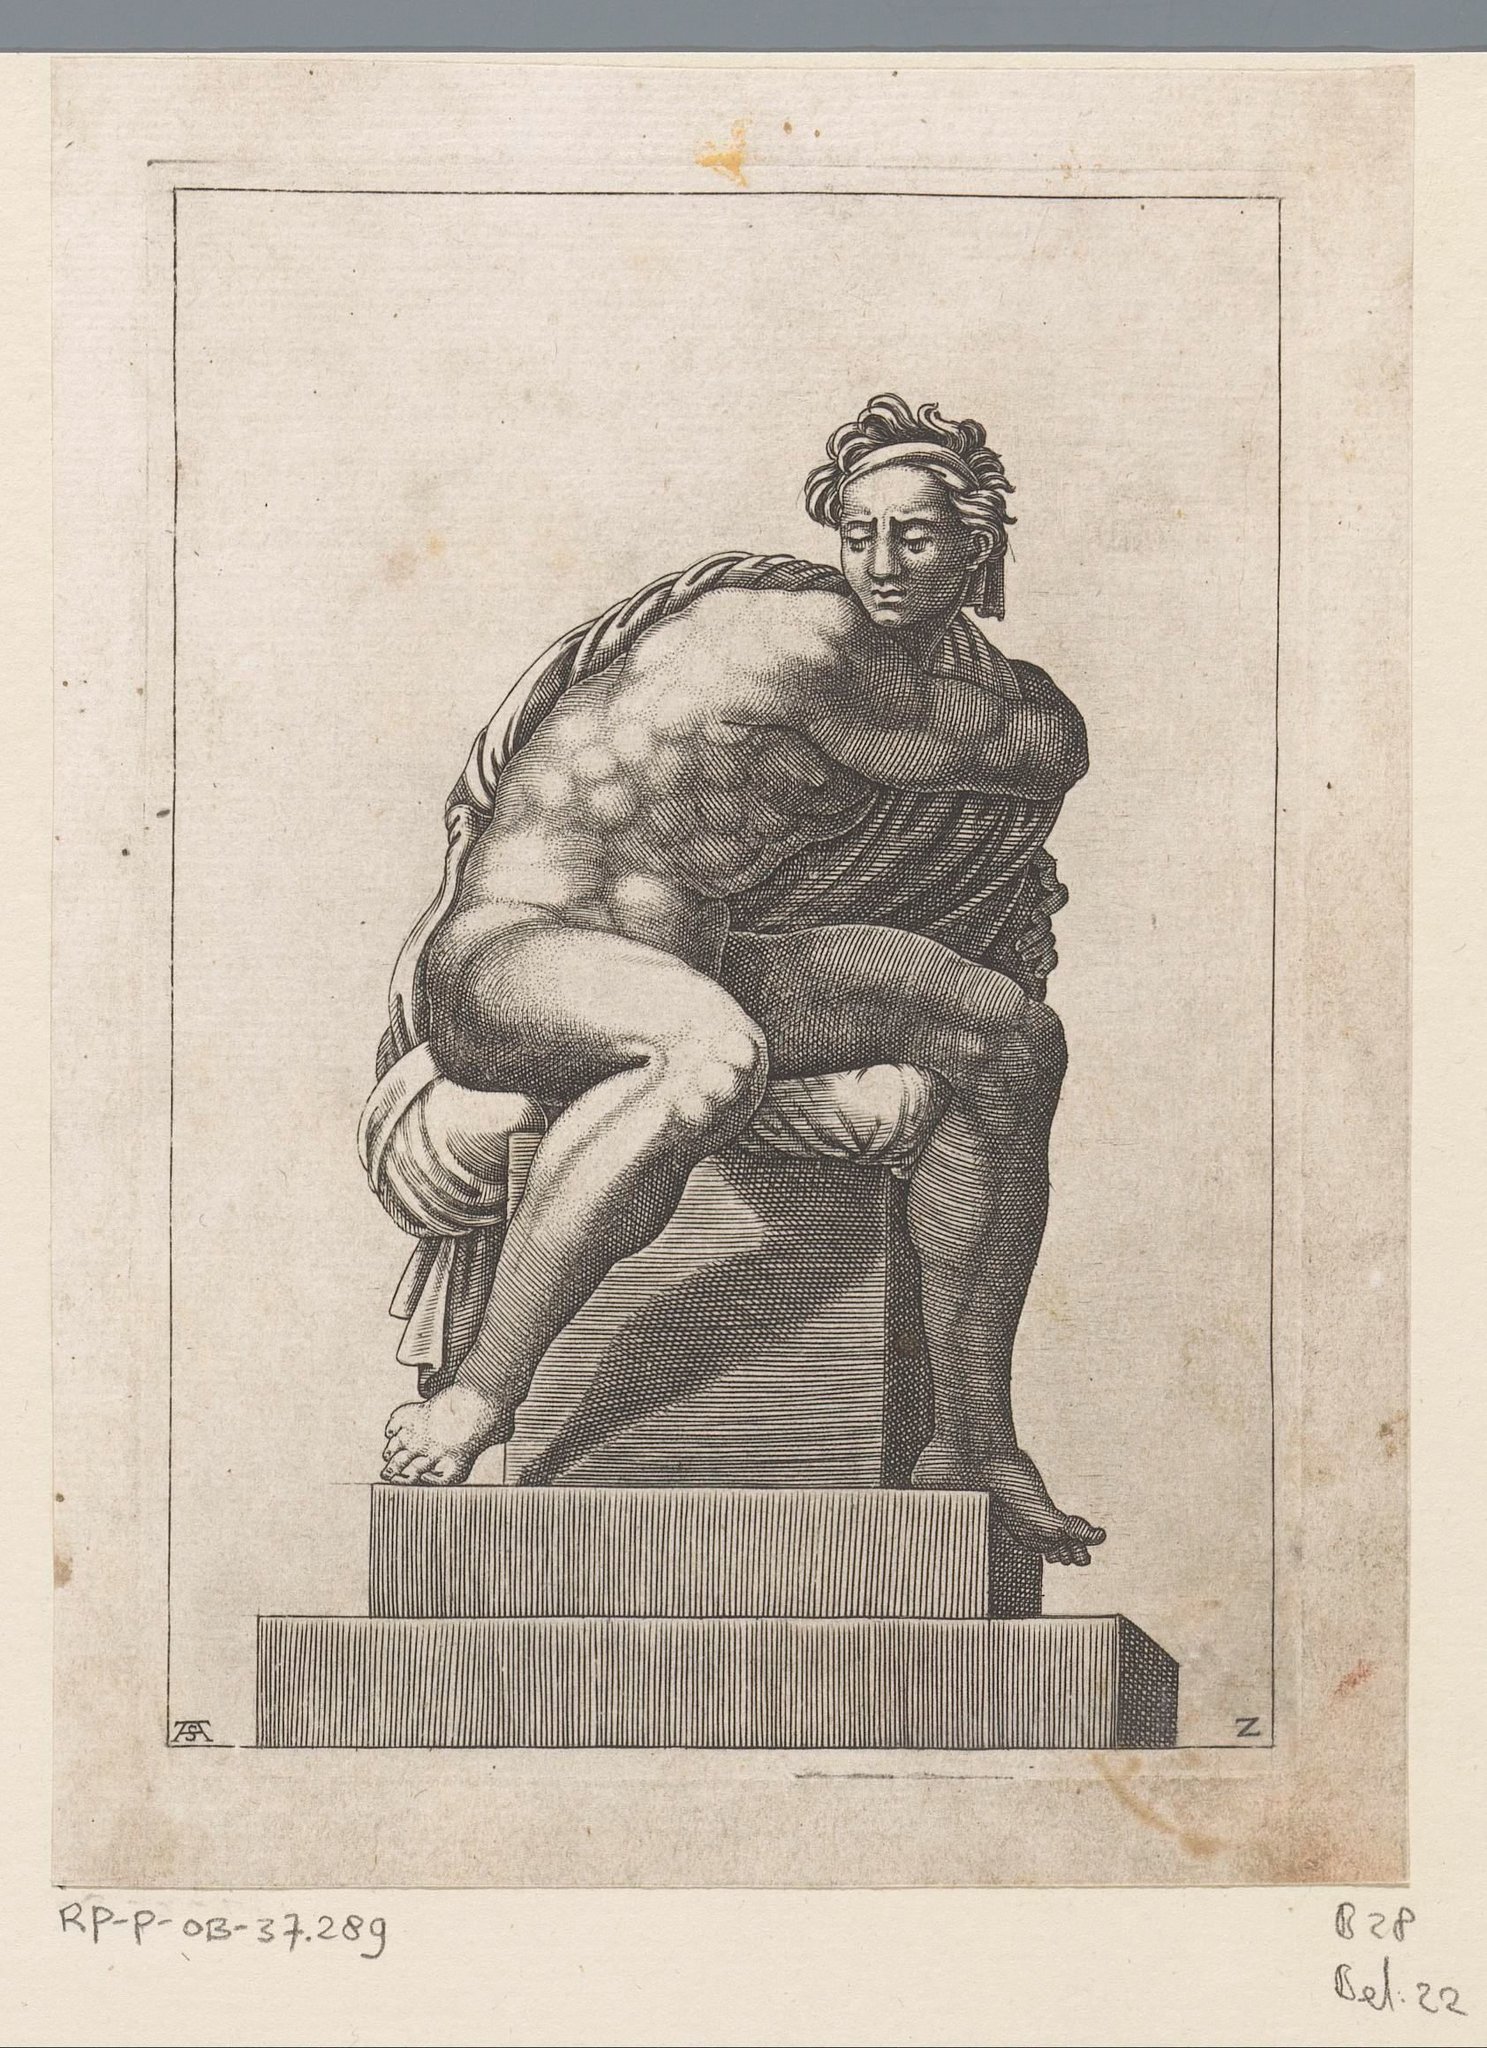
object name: print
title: Schilderingen in de Sixtijnse kapel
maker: adamo scultori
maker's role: painter, print maker, sculptor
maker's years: 1530-1585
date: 1585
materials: paper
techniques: engraving, intaglio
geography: vatican city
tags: the (nude) human figure; 'corpo humano' (ripa)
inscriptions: collector's mark: Lugt 240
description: Deze prent maakt deel uit van een serie bestaande uit een titelprent en 72 prenten naar schilderingen door Michelangelo in de Sixtijnse Kapel in het Vaticaan.